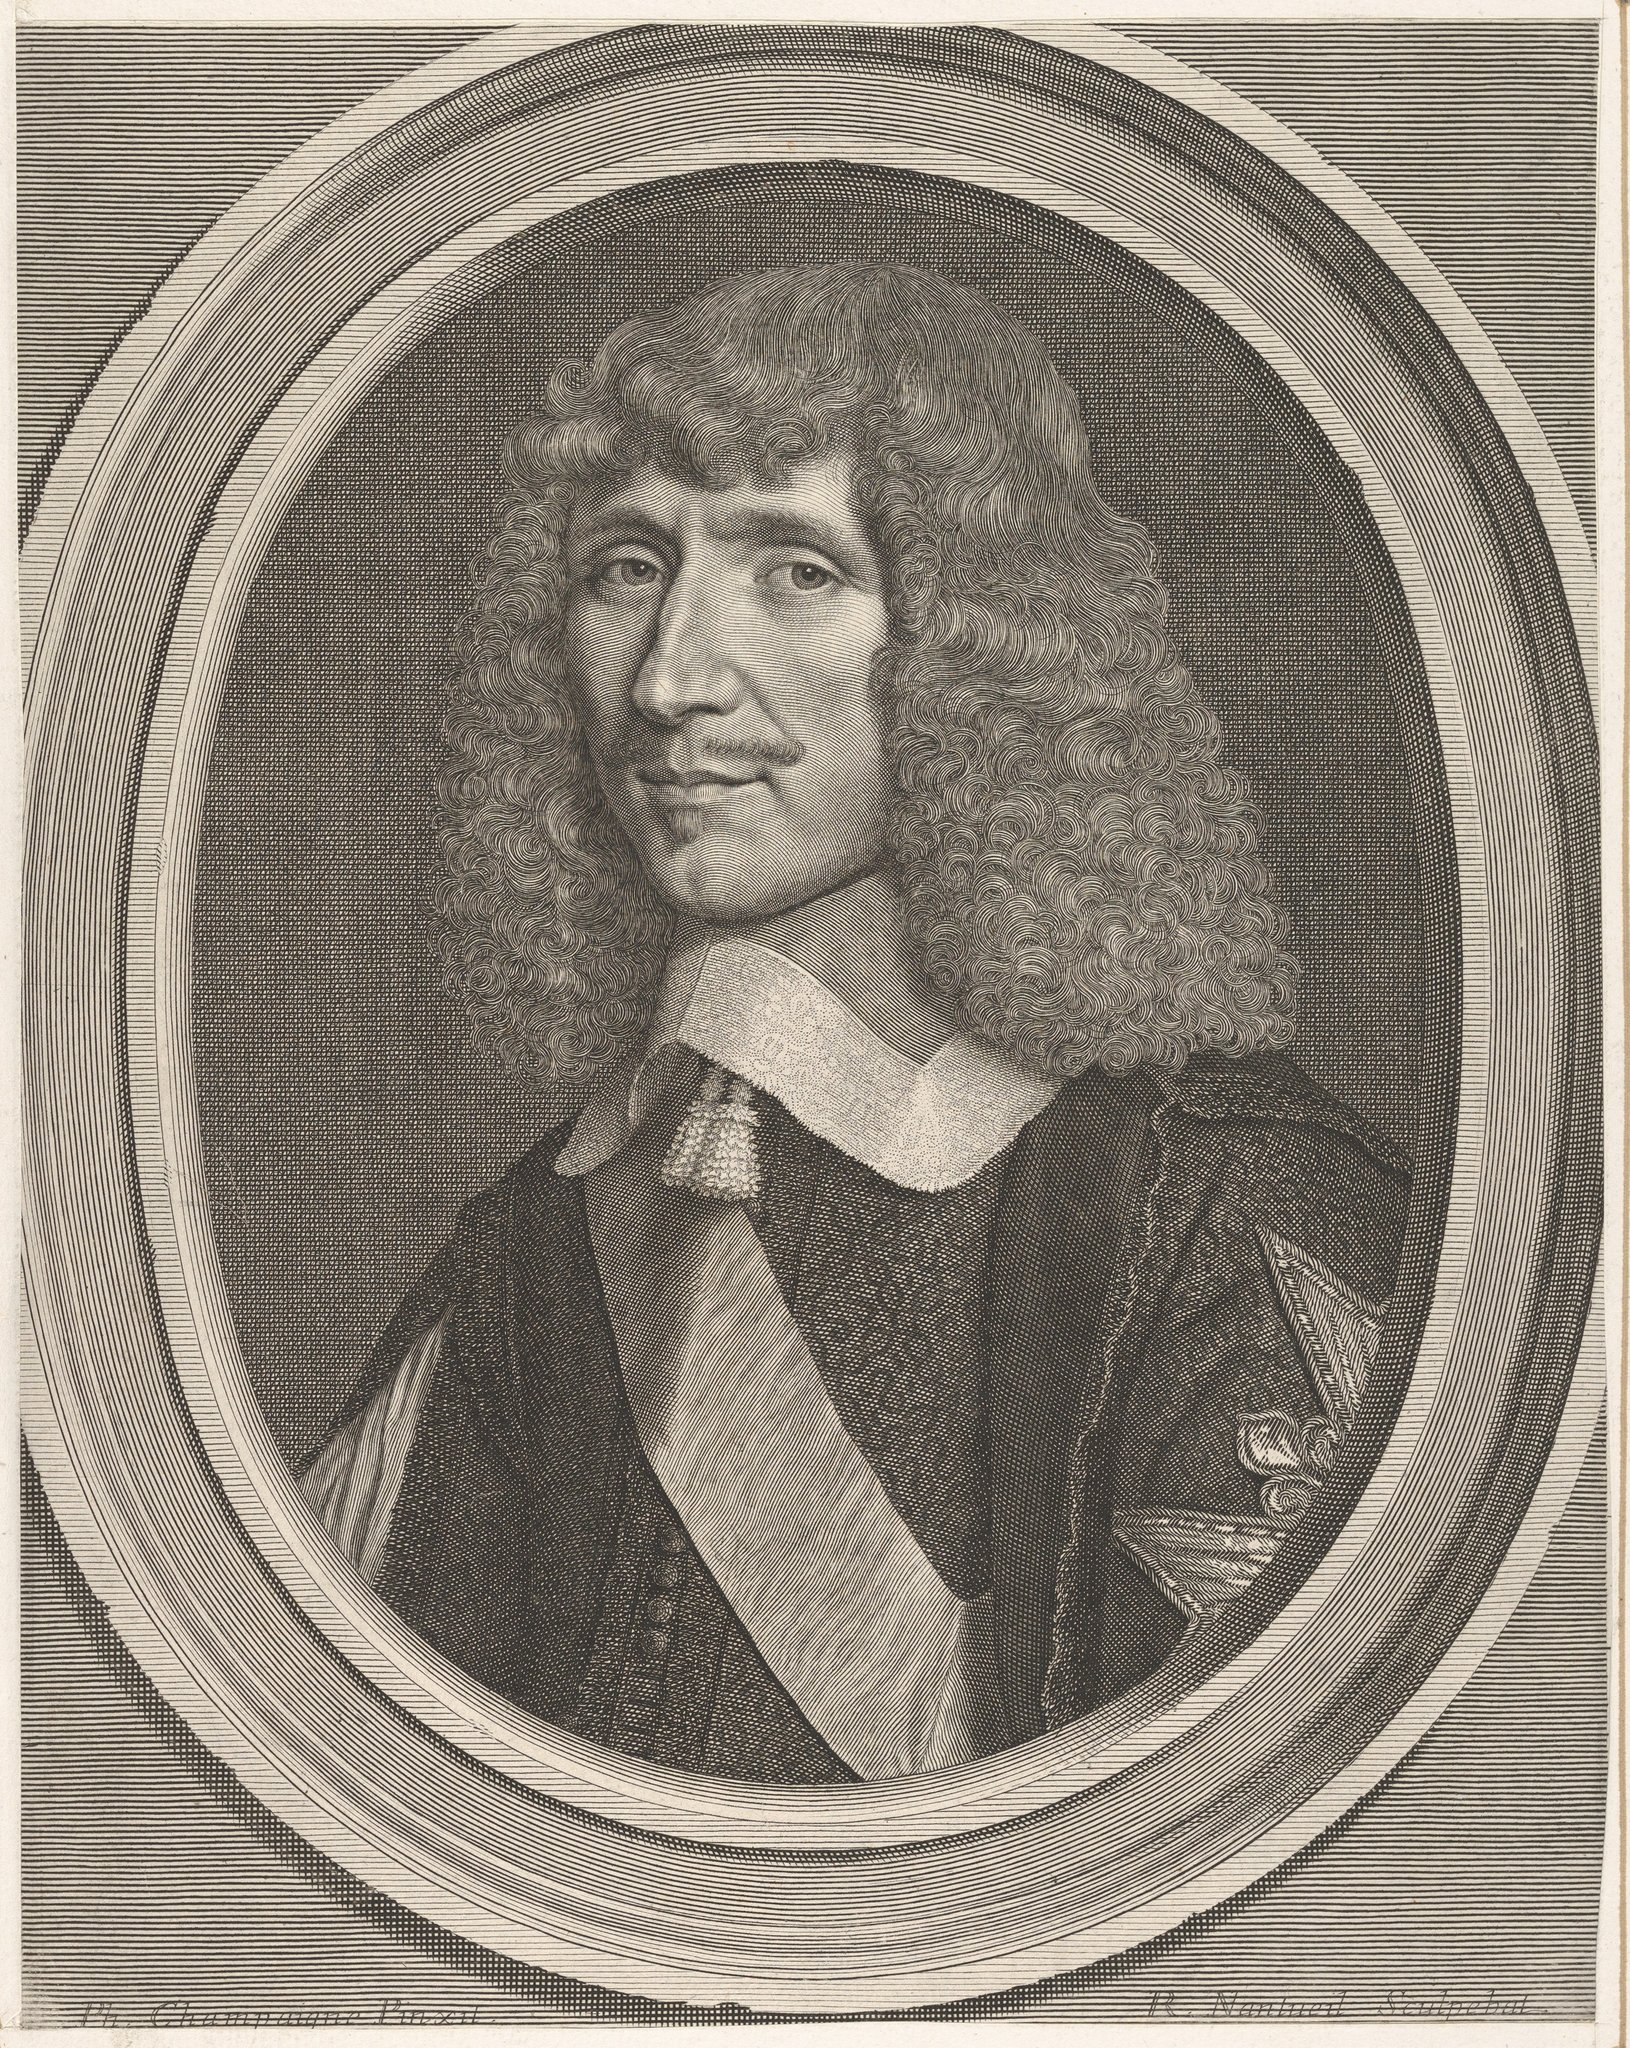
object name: print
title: Léon-Bouthillier, comte de Chavigny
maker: robert nanteuil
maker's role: artist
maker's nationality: french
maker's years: 1623-1678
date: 1651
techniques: engraving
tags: men,portraits